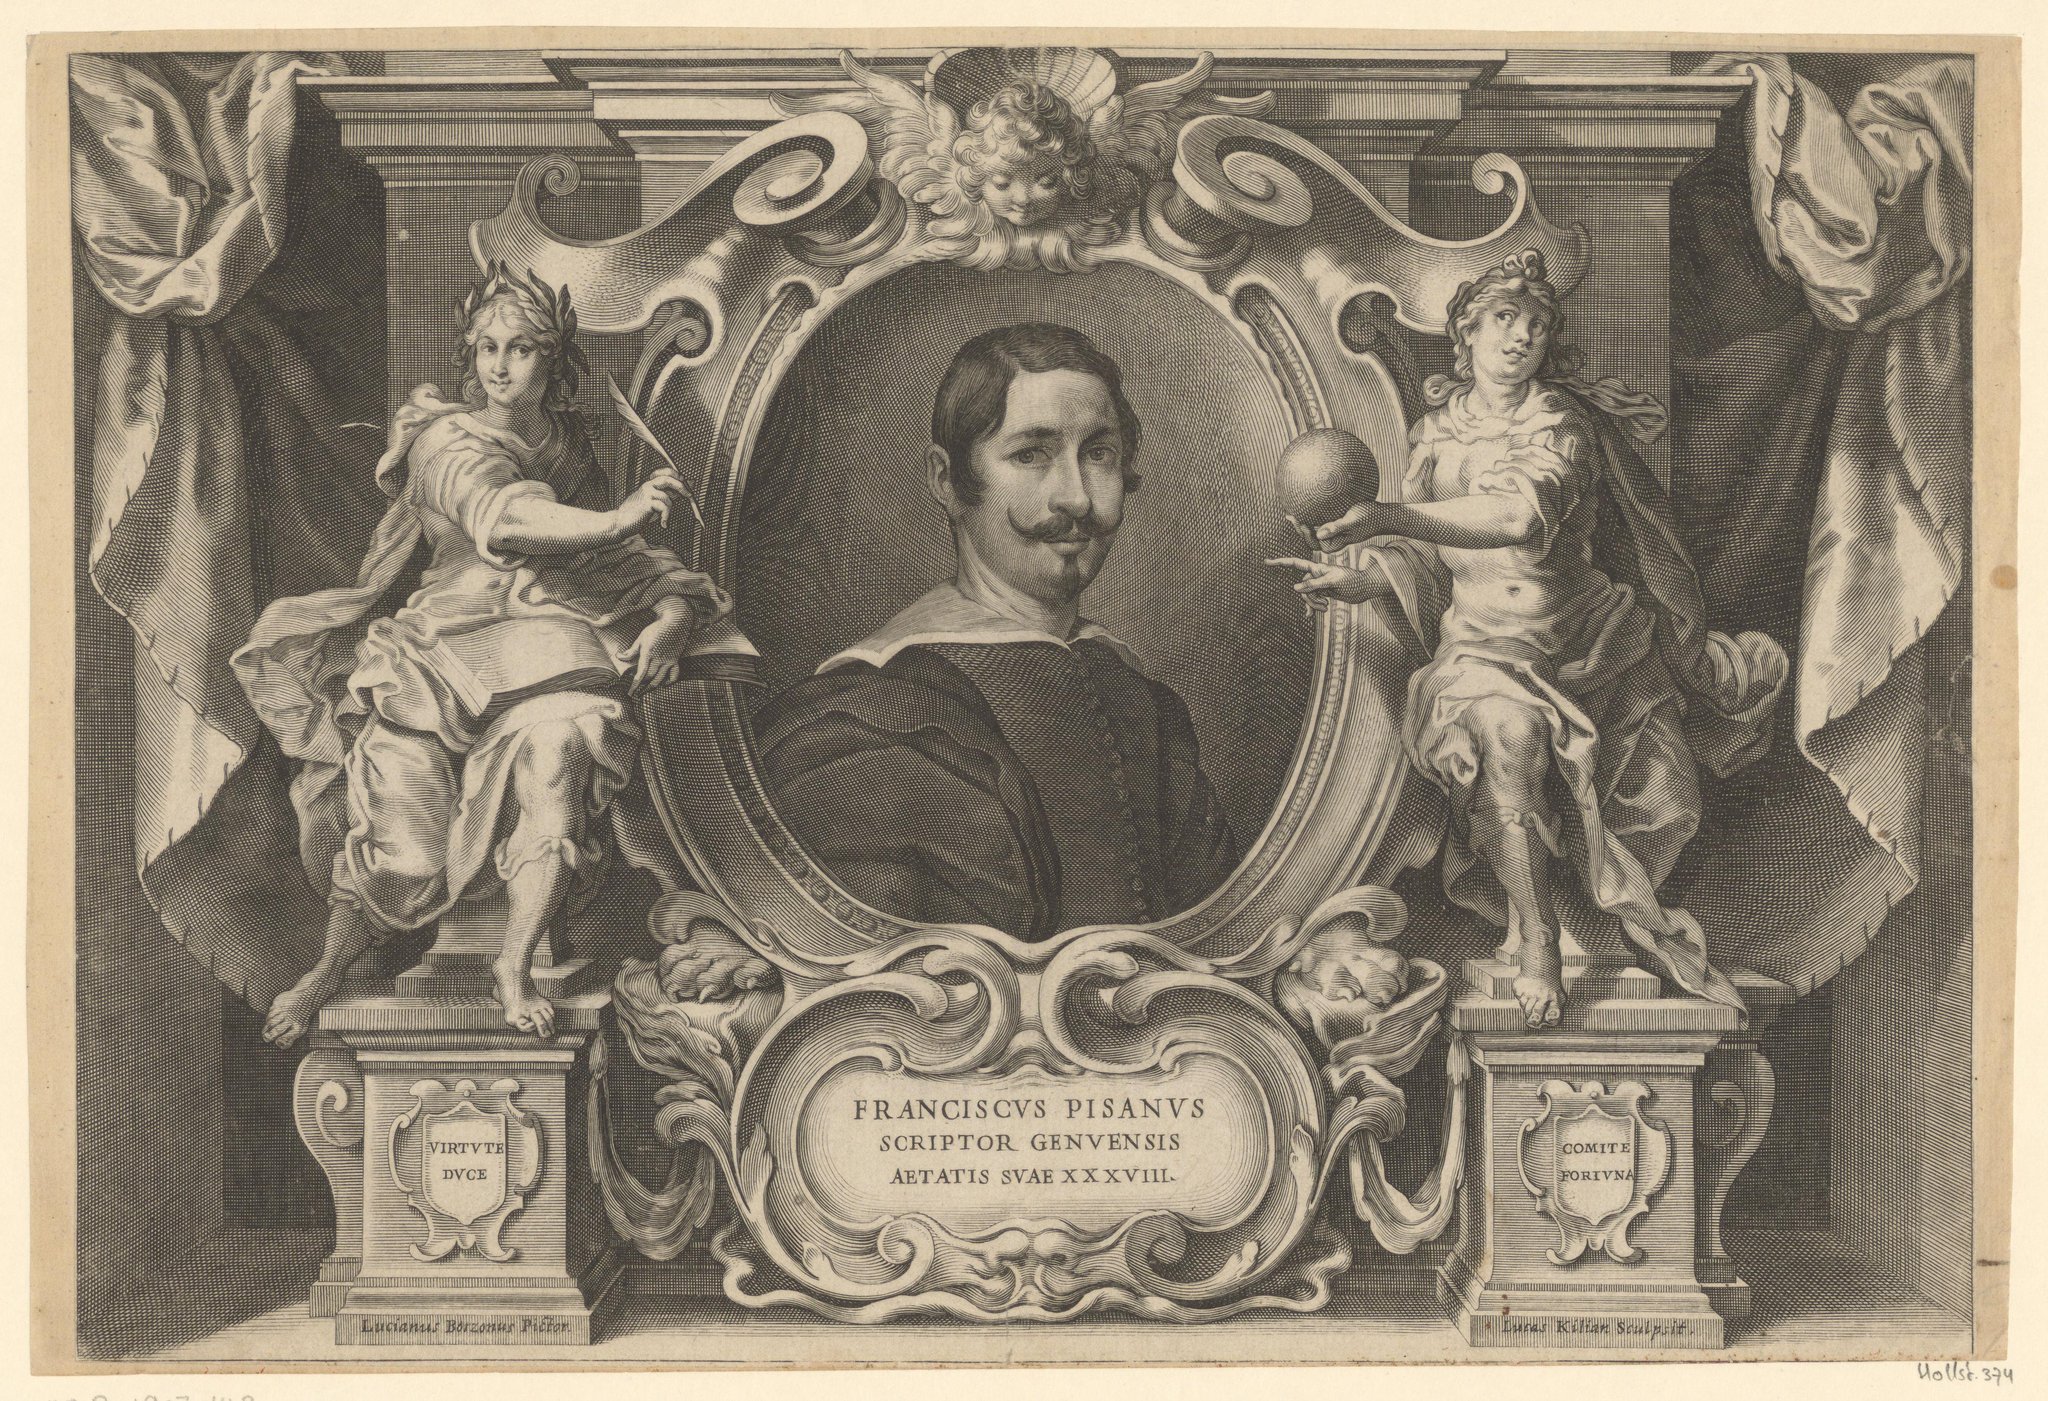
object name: print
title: Portret van Franciscus Pisani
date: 1589-1637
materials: paper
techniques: engraving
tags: painter, francescus pisani, virtus as roman personification, historical persons, portrait, self-portrait of painter, fortuna as roman personification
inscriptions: collector's mark: Lugt 2228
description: Tekst in het Latijn in de cartouche en op de sokkels. Op sokkels aan weerszijden van het portretmedaillon vertolken twee beelden de uitspraak 'Virtute duce comite fortuna', vrij te vertalen als 'geleid door deugd en vergezeld door (goed) fortuin'.